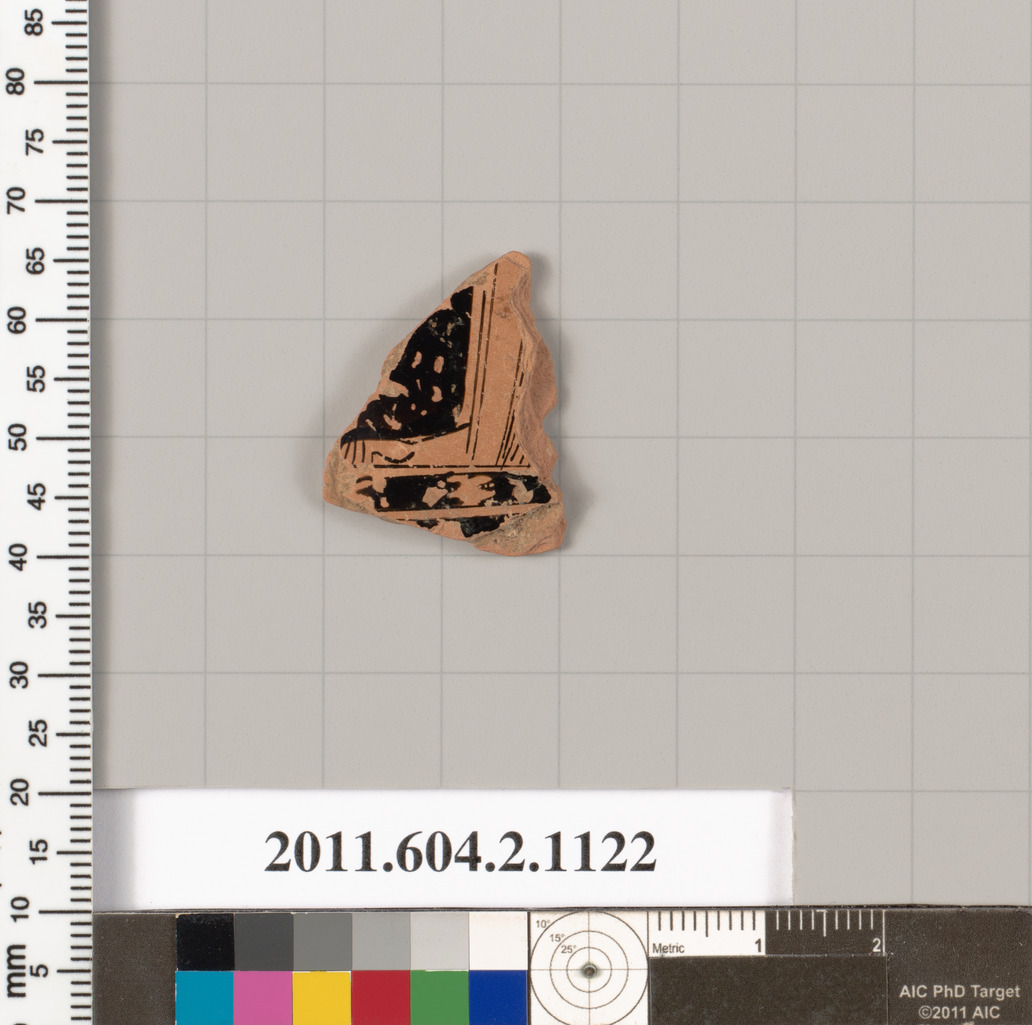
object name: lekythos fragment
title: Terracotta fragment of a squat lekythos (oil flask)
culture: greek, attic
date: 450-426 BCE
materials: terracotta